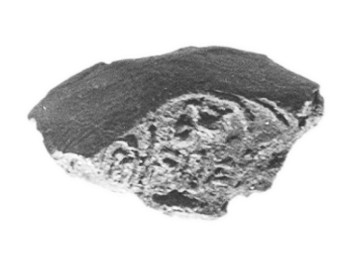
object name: sealing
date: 1981-1640 BCE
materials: mud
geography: egypt